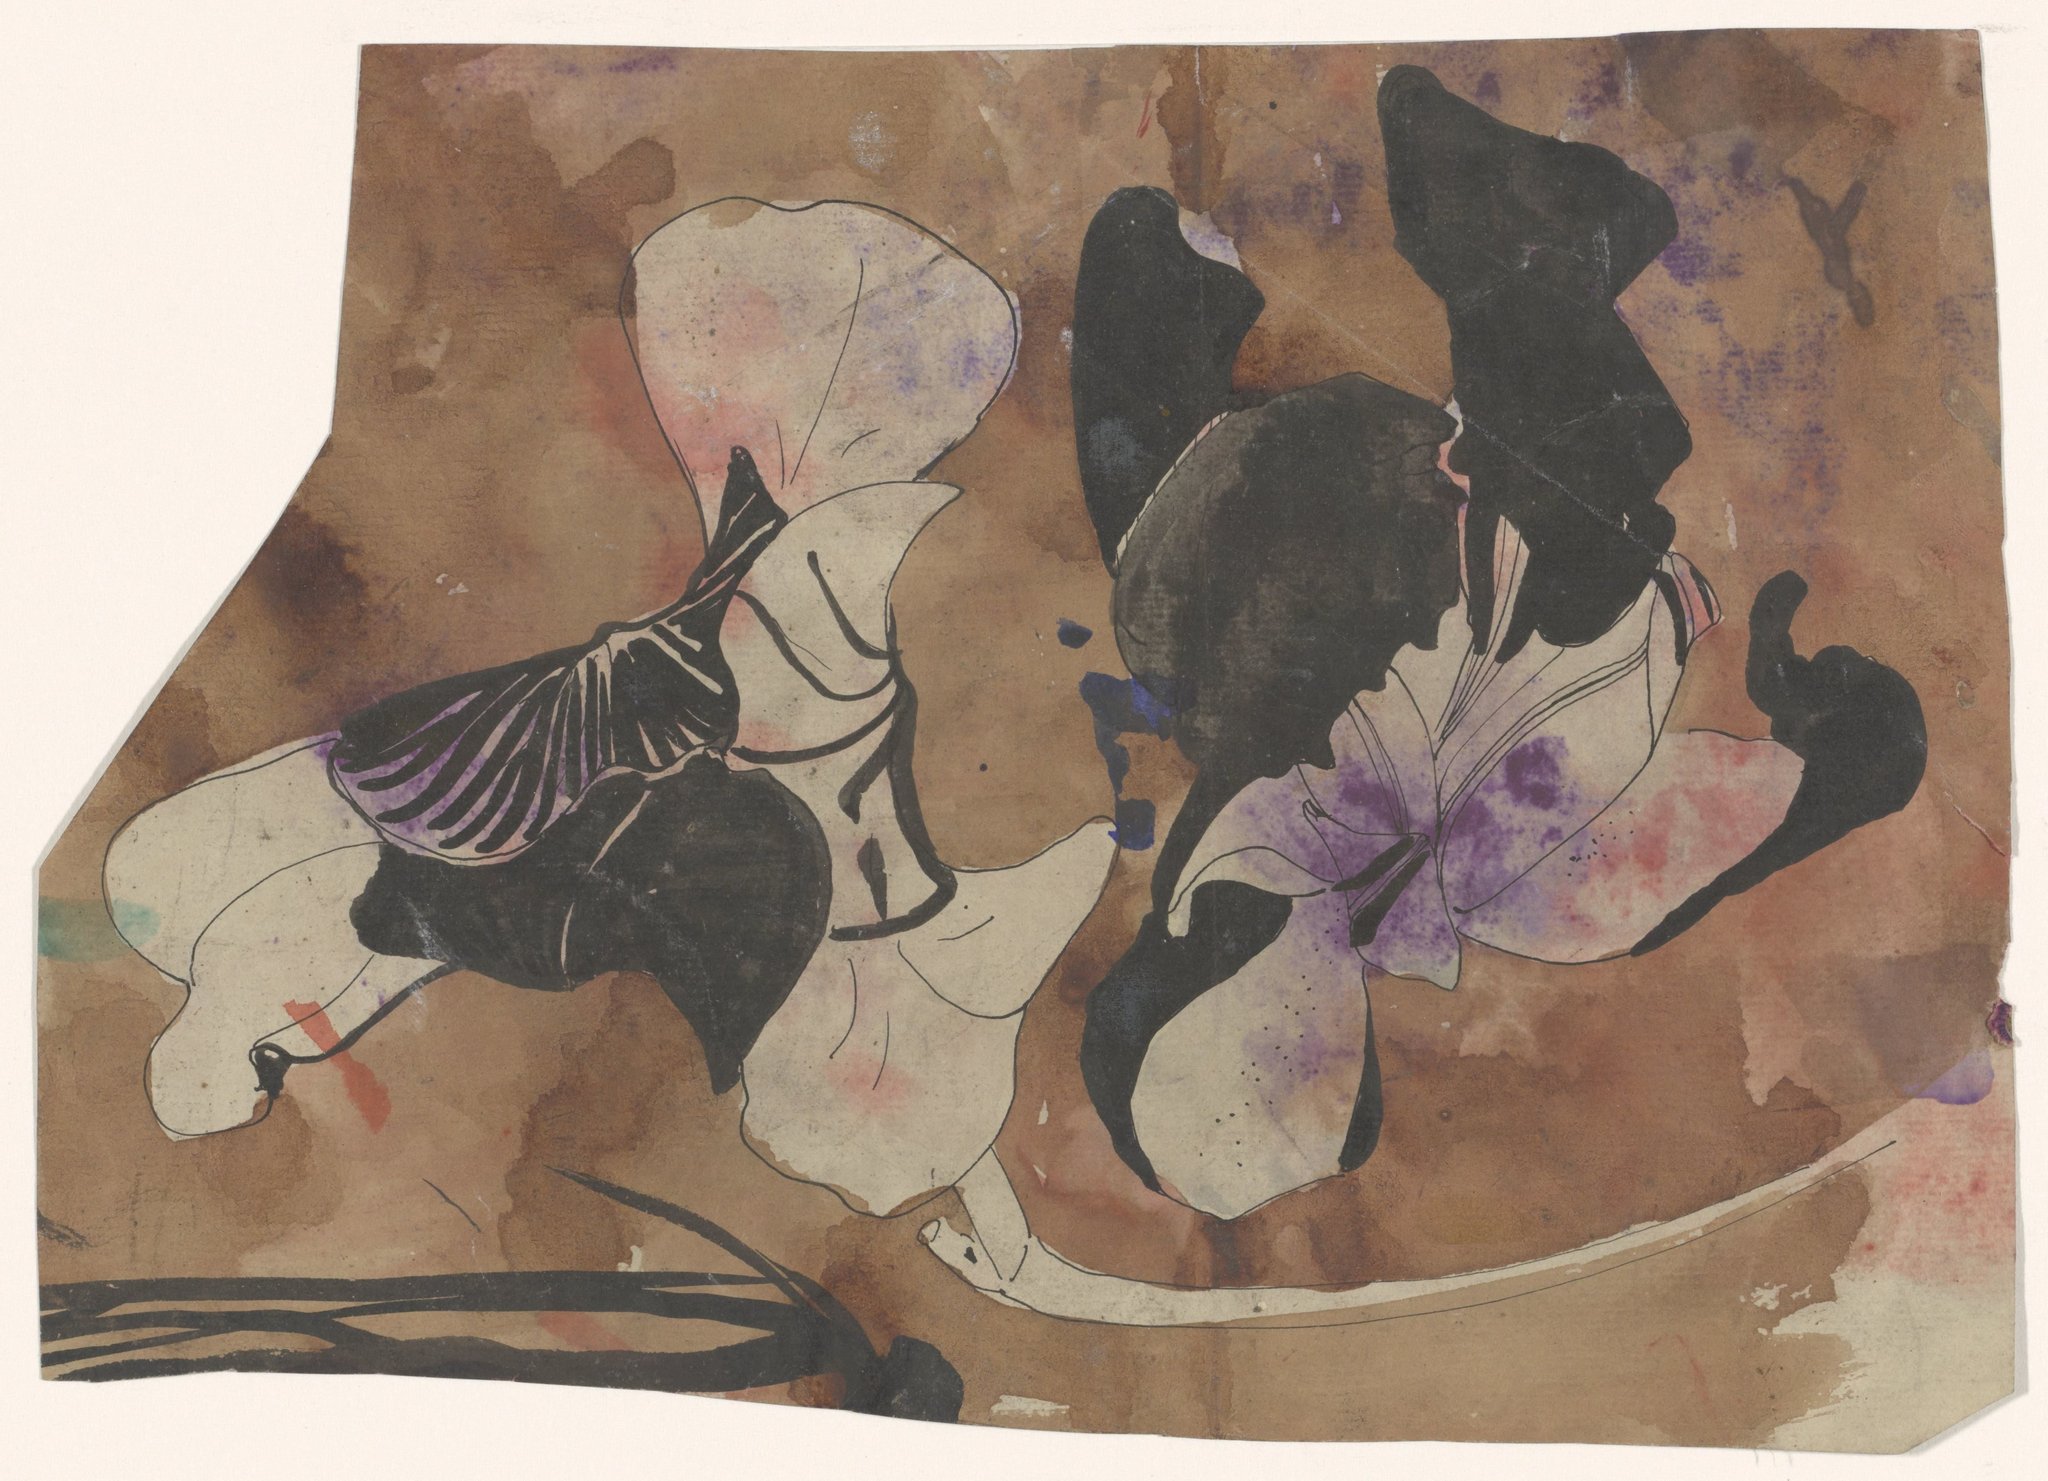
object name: drawing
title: Bloemstudie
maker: carel adolph lion cachet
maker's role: draughtsman, print maker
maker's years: 1864-1945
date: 1874-1945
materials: ink, paper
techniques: brush, pen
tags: flowers